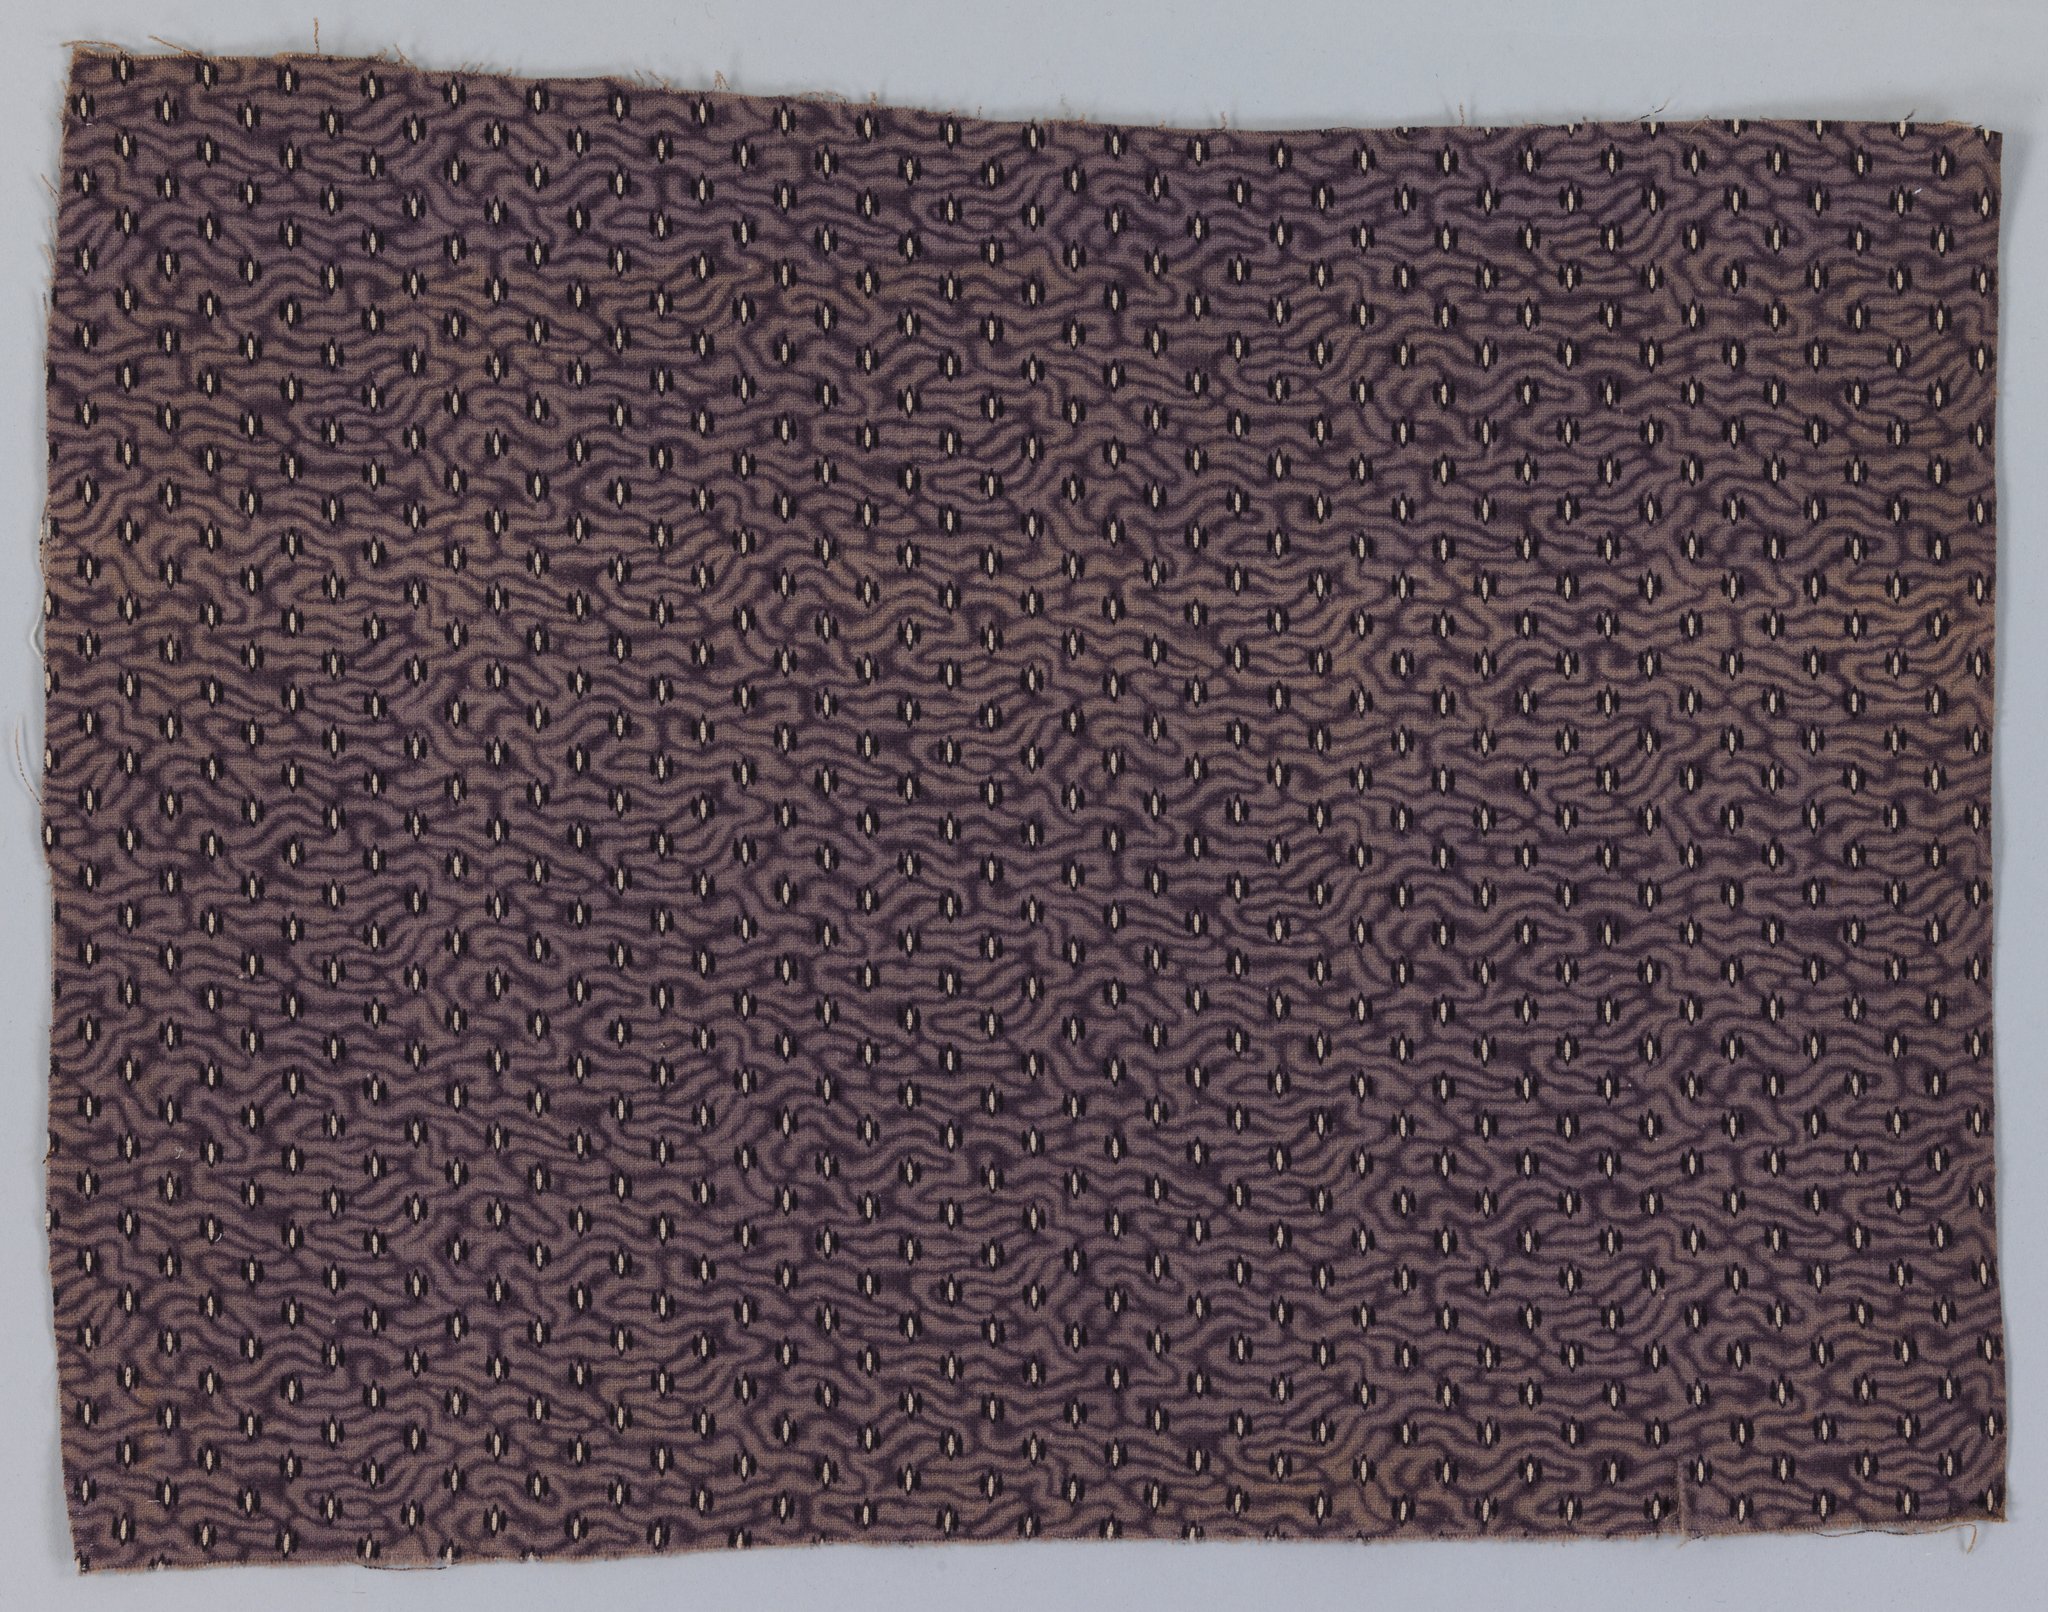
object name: piece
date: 1801-1900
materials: cotton